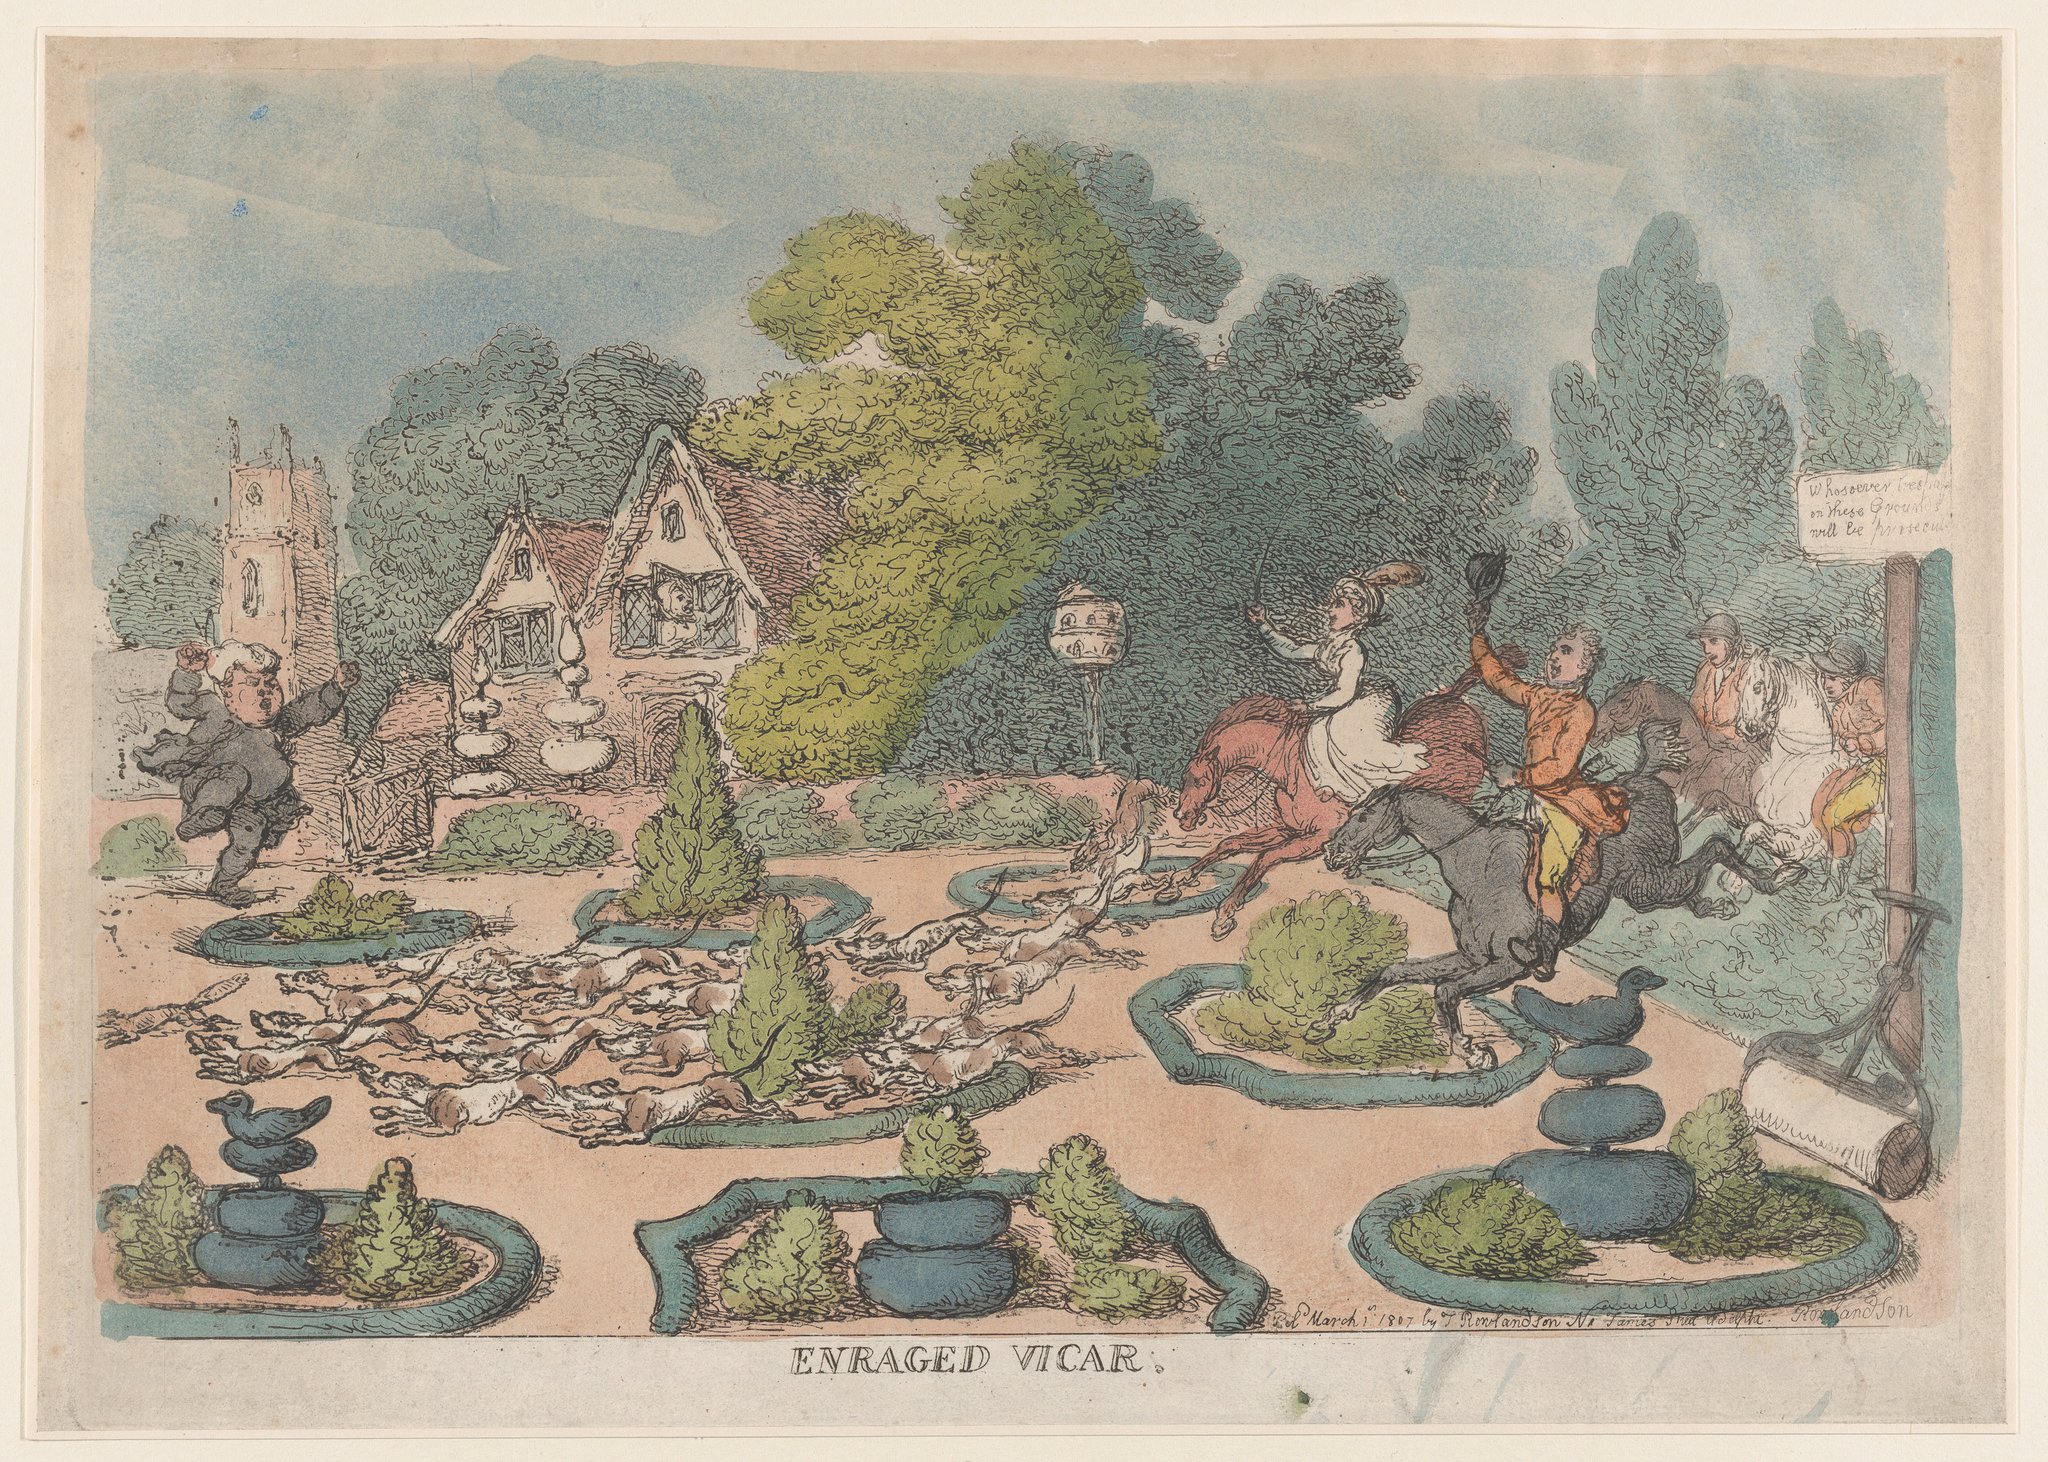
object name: print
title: Enraged Vicar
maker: thomas rowlandson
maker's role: artist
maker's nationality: british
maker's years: 1757-1827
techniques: etching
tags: satire,gardens,men,women,hunting,dogs,horses